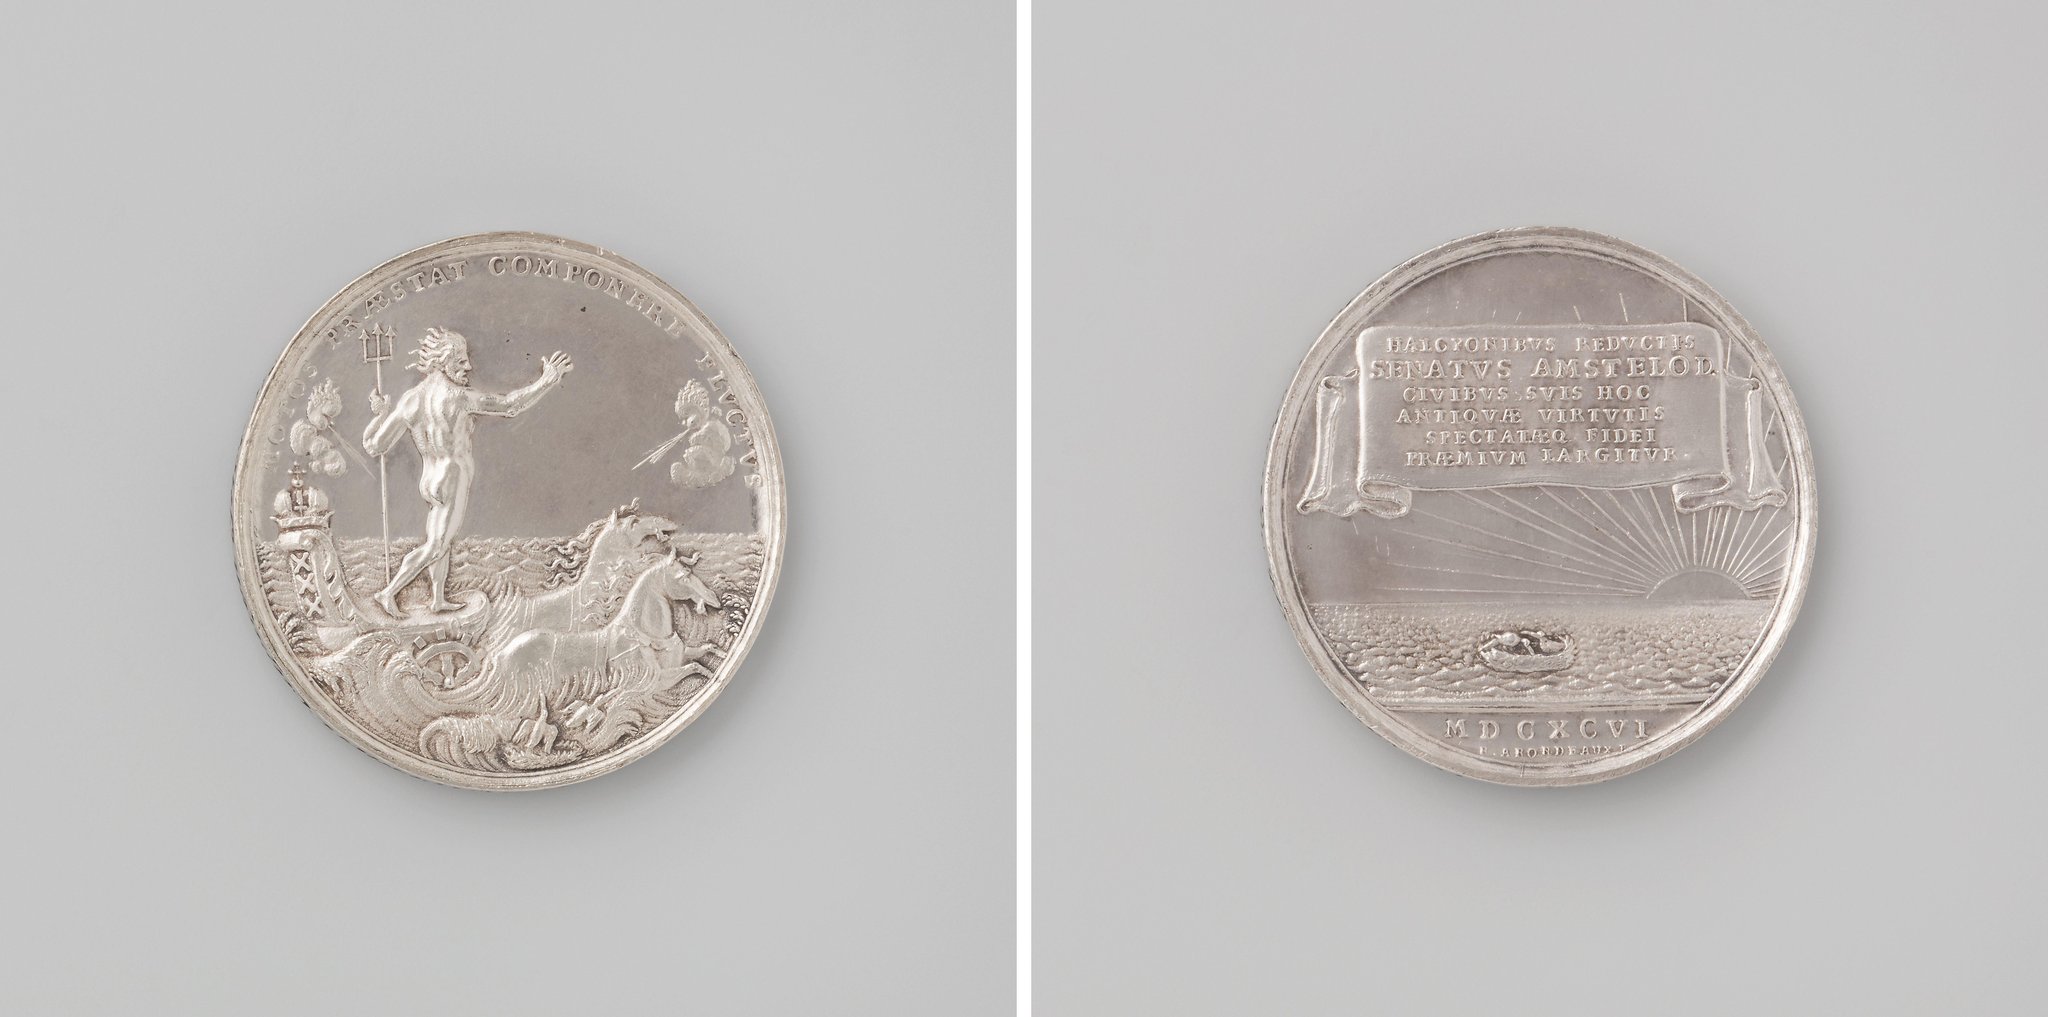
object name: history medal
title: Stillen van het aansprekersoproer te Amsterdam, ter ere van Jan Buste, adelborst onder Gilles van Heemert, kapitein in wijk 23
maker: reynier arondeaux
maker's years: 1678-1727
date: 1696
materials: silver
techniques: engraving, striking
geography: nijmegen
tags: amsterdam